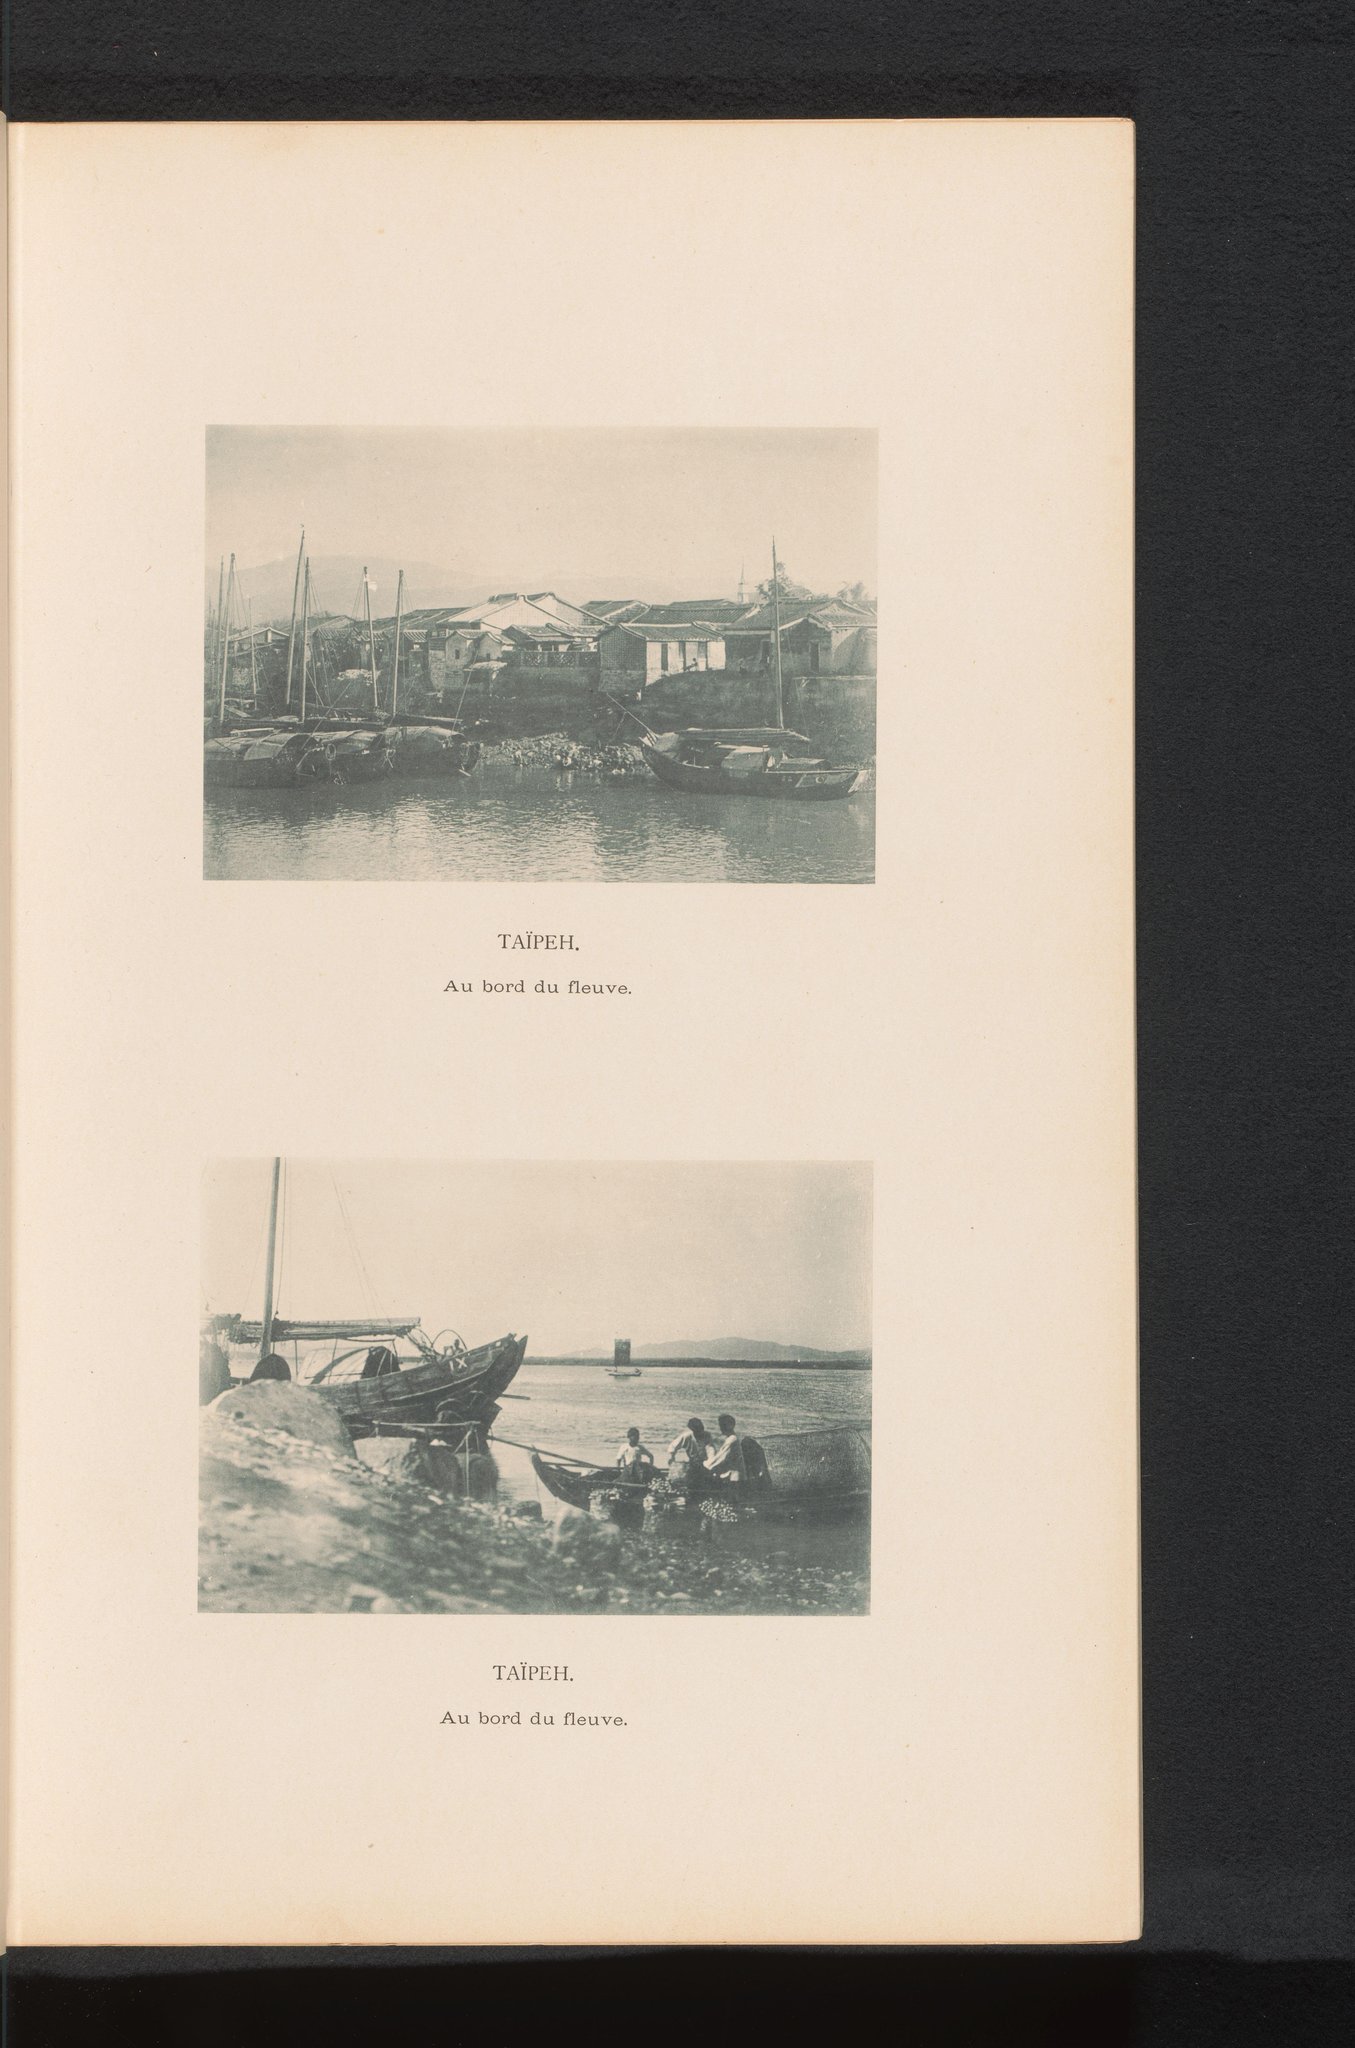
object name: page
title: Taïpeh. Au bord du fleuve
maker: Anonymous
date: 1891-1896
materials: paper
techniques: photograph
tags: sailing-ship, sailing-boat, river (+ landscape with figures, staffage)